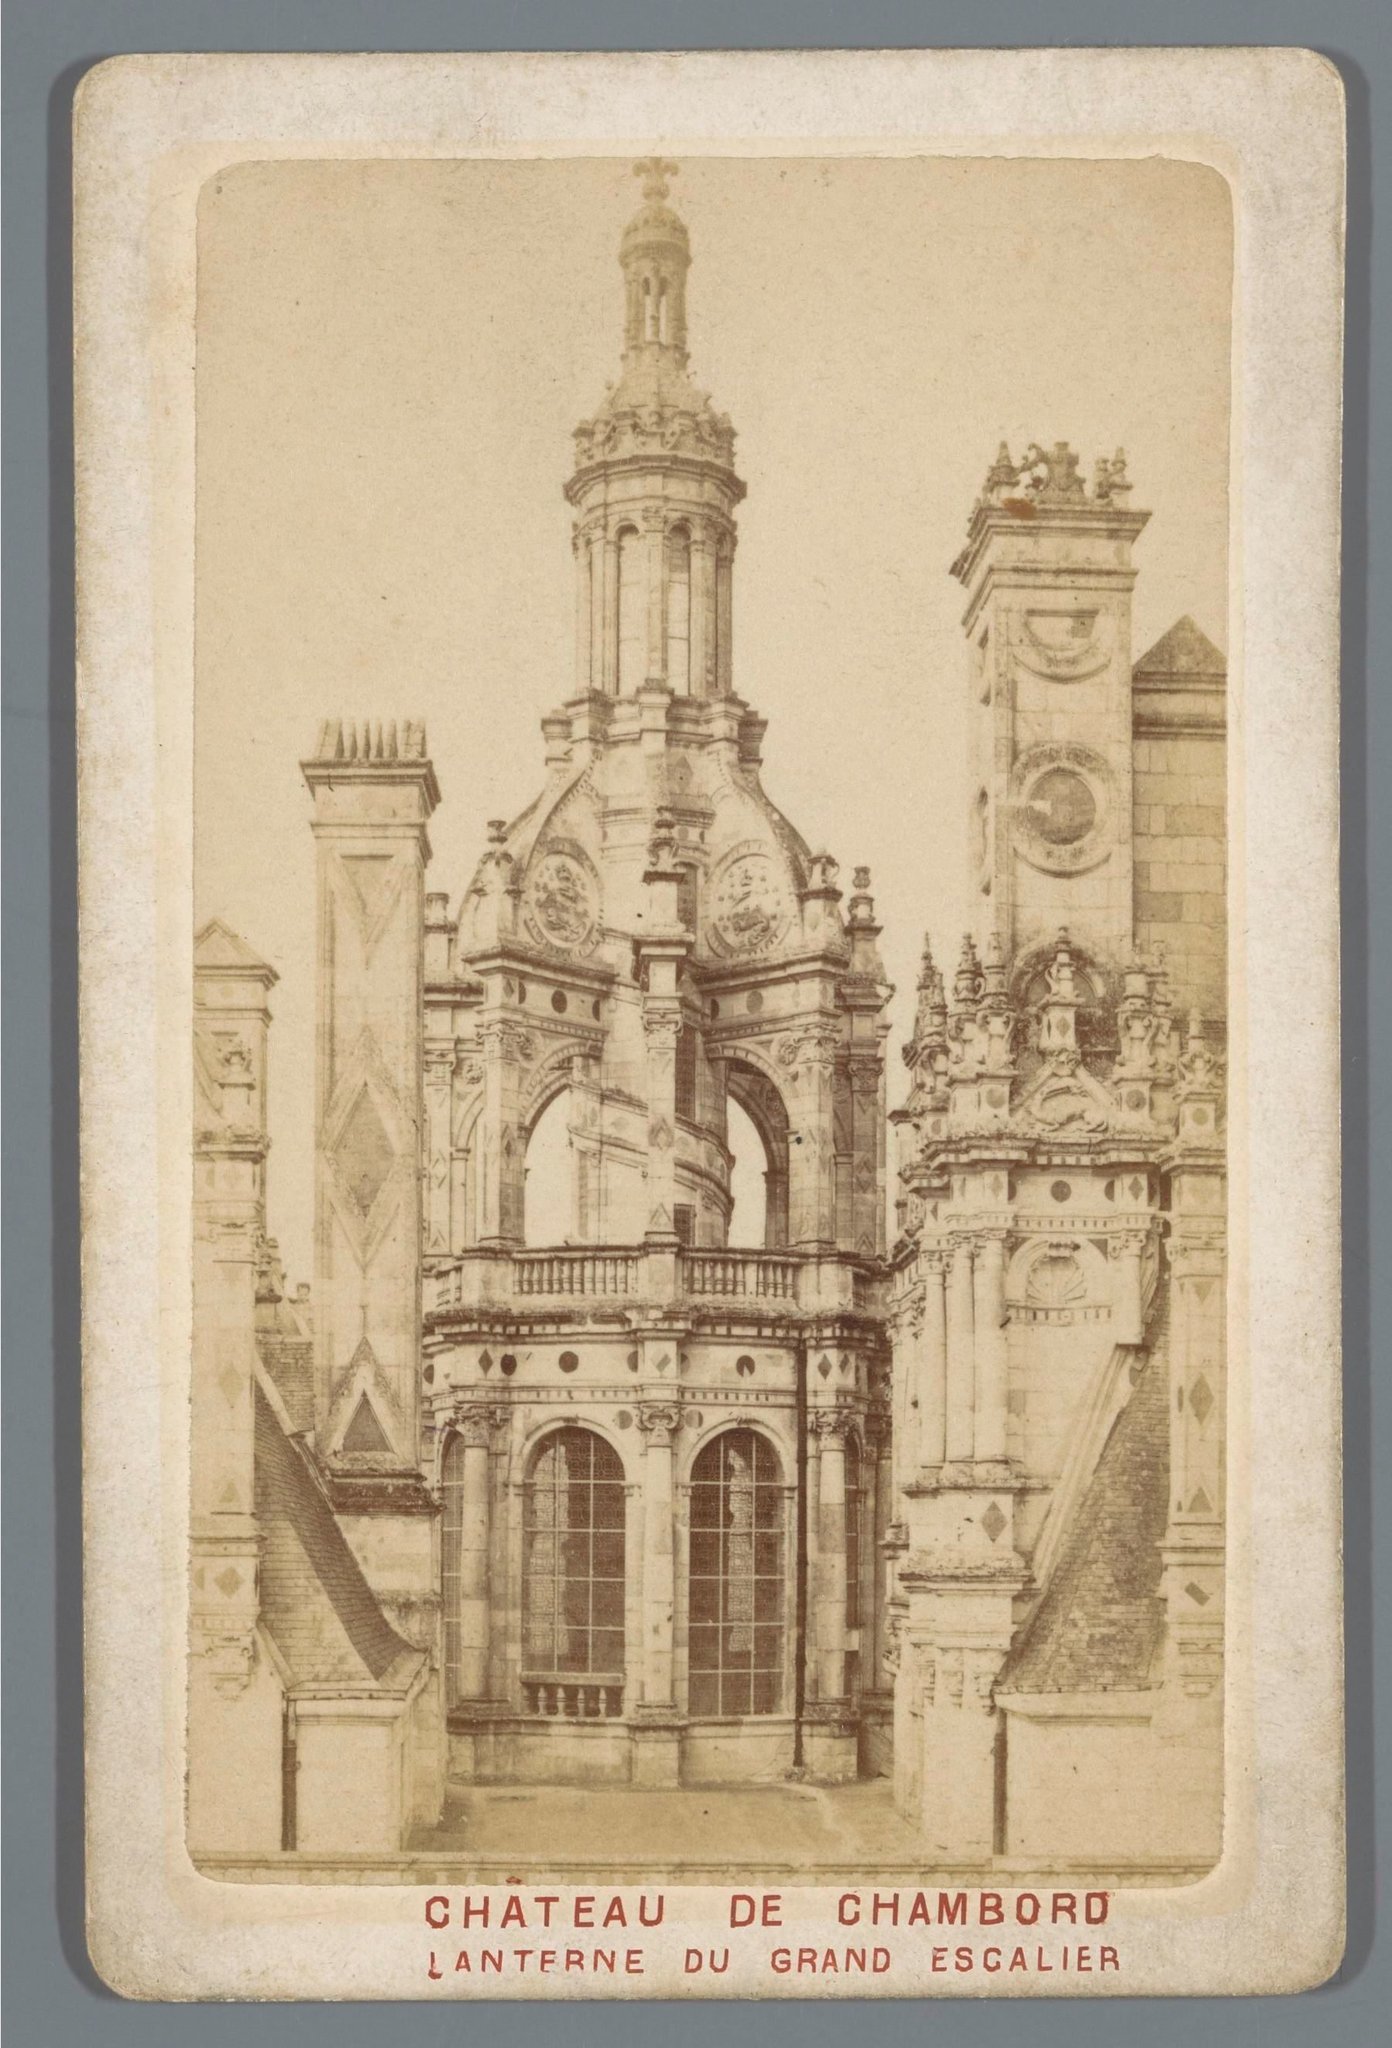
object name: carte de visite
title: Lanterne du Grand Escalier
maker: Anonymous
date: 1855-1885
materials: cardboard, paper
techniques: albumen print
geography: chambord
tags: castle